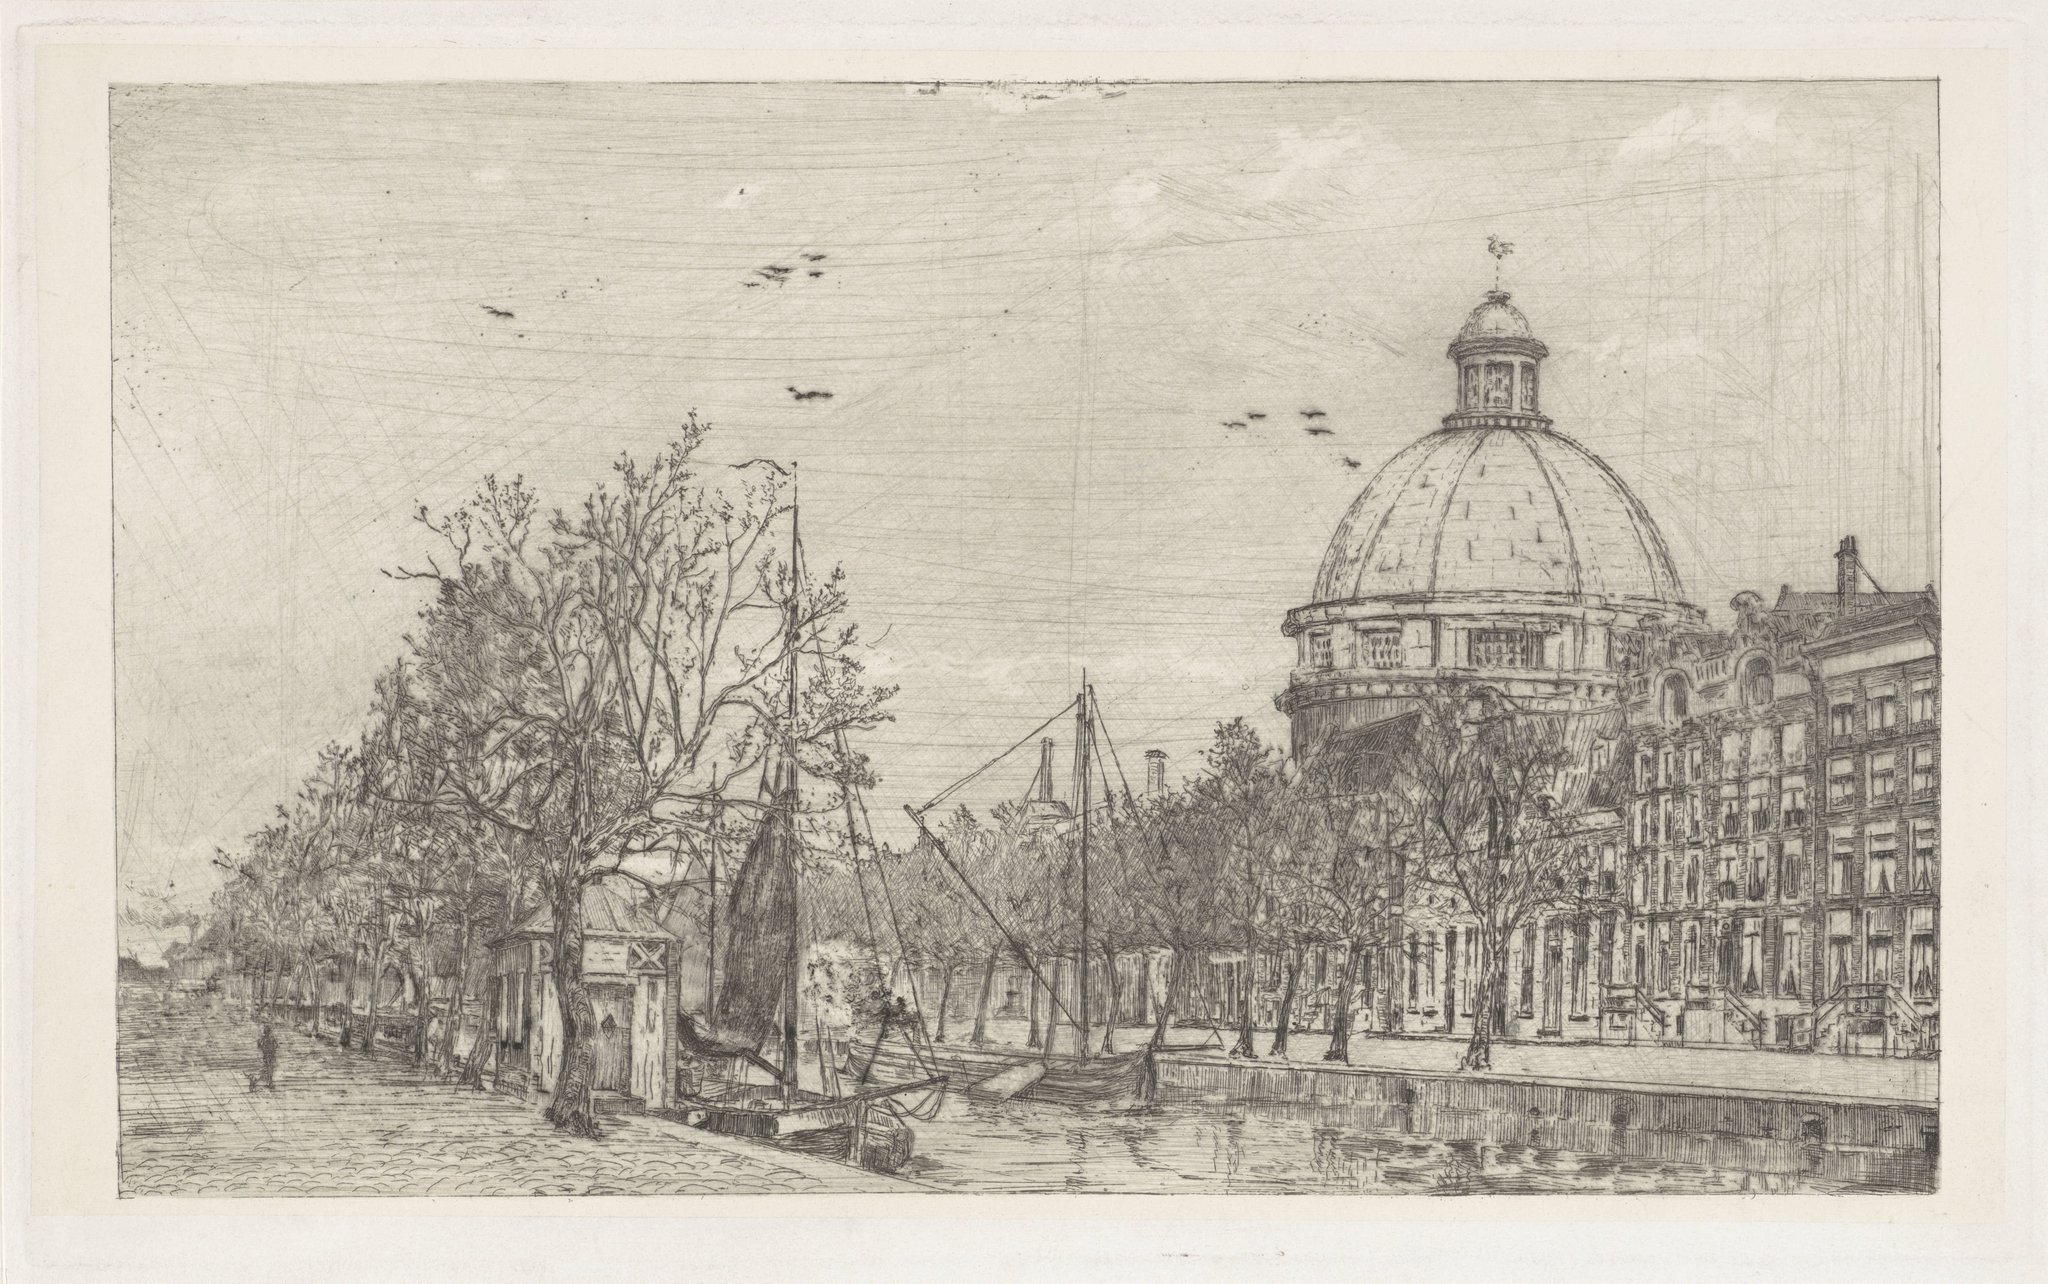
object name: print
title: Singel met de Ronde Lutherse kerk te Amsterdam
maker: frans schikkinger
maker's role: print maker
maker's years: 1838-1902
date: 1848-1902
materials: paper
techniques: drypoint, etching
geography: amsterdam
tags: canals, waters (in city), amsterdam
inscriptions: collector's mark: Lugt 2228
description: Gezicht op de Singel met de Ronde Lutherse kerk of Koepelkerk te Amsterdam. In de gracht liggen twee schepen aangemeerd.